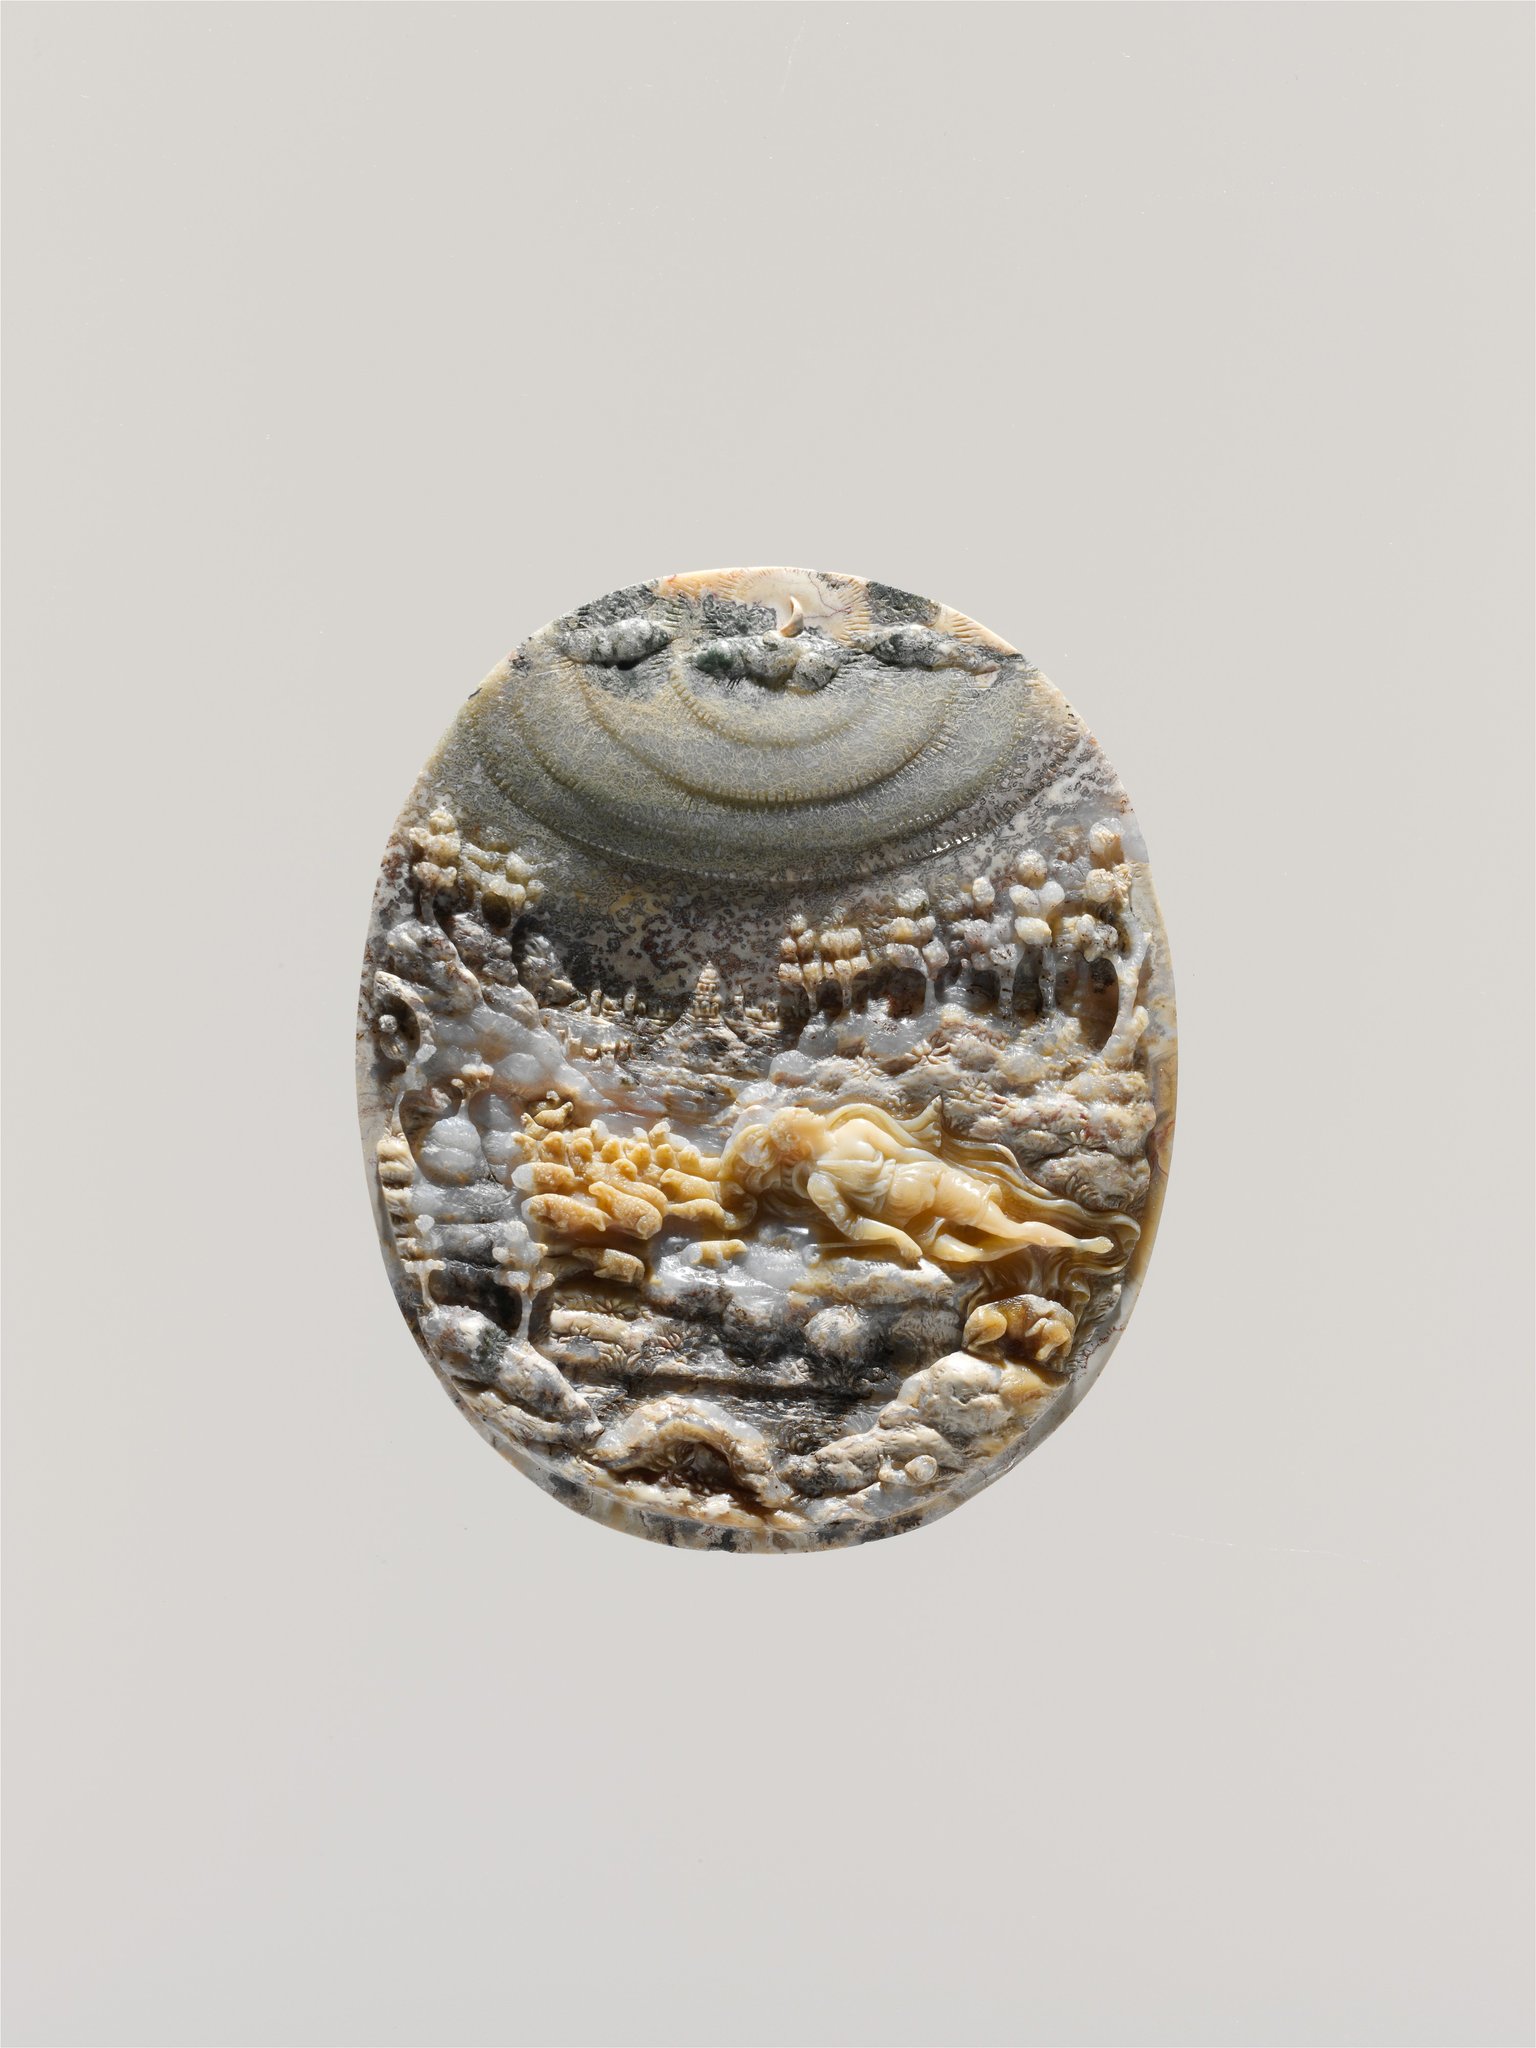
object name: cameo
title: Sleeping shepherdess in a moonlit landscape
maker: alessandro masnago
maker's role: artist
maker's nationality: italian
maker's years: 1520-1620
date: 1567-1600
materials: stone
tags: sleeping,women,dogs,sheep,shepherds